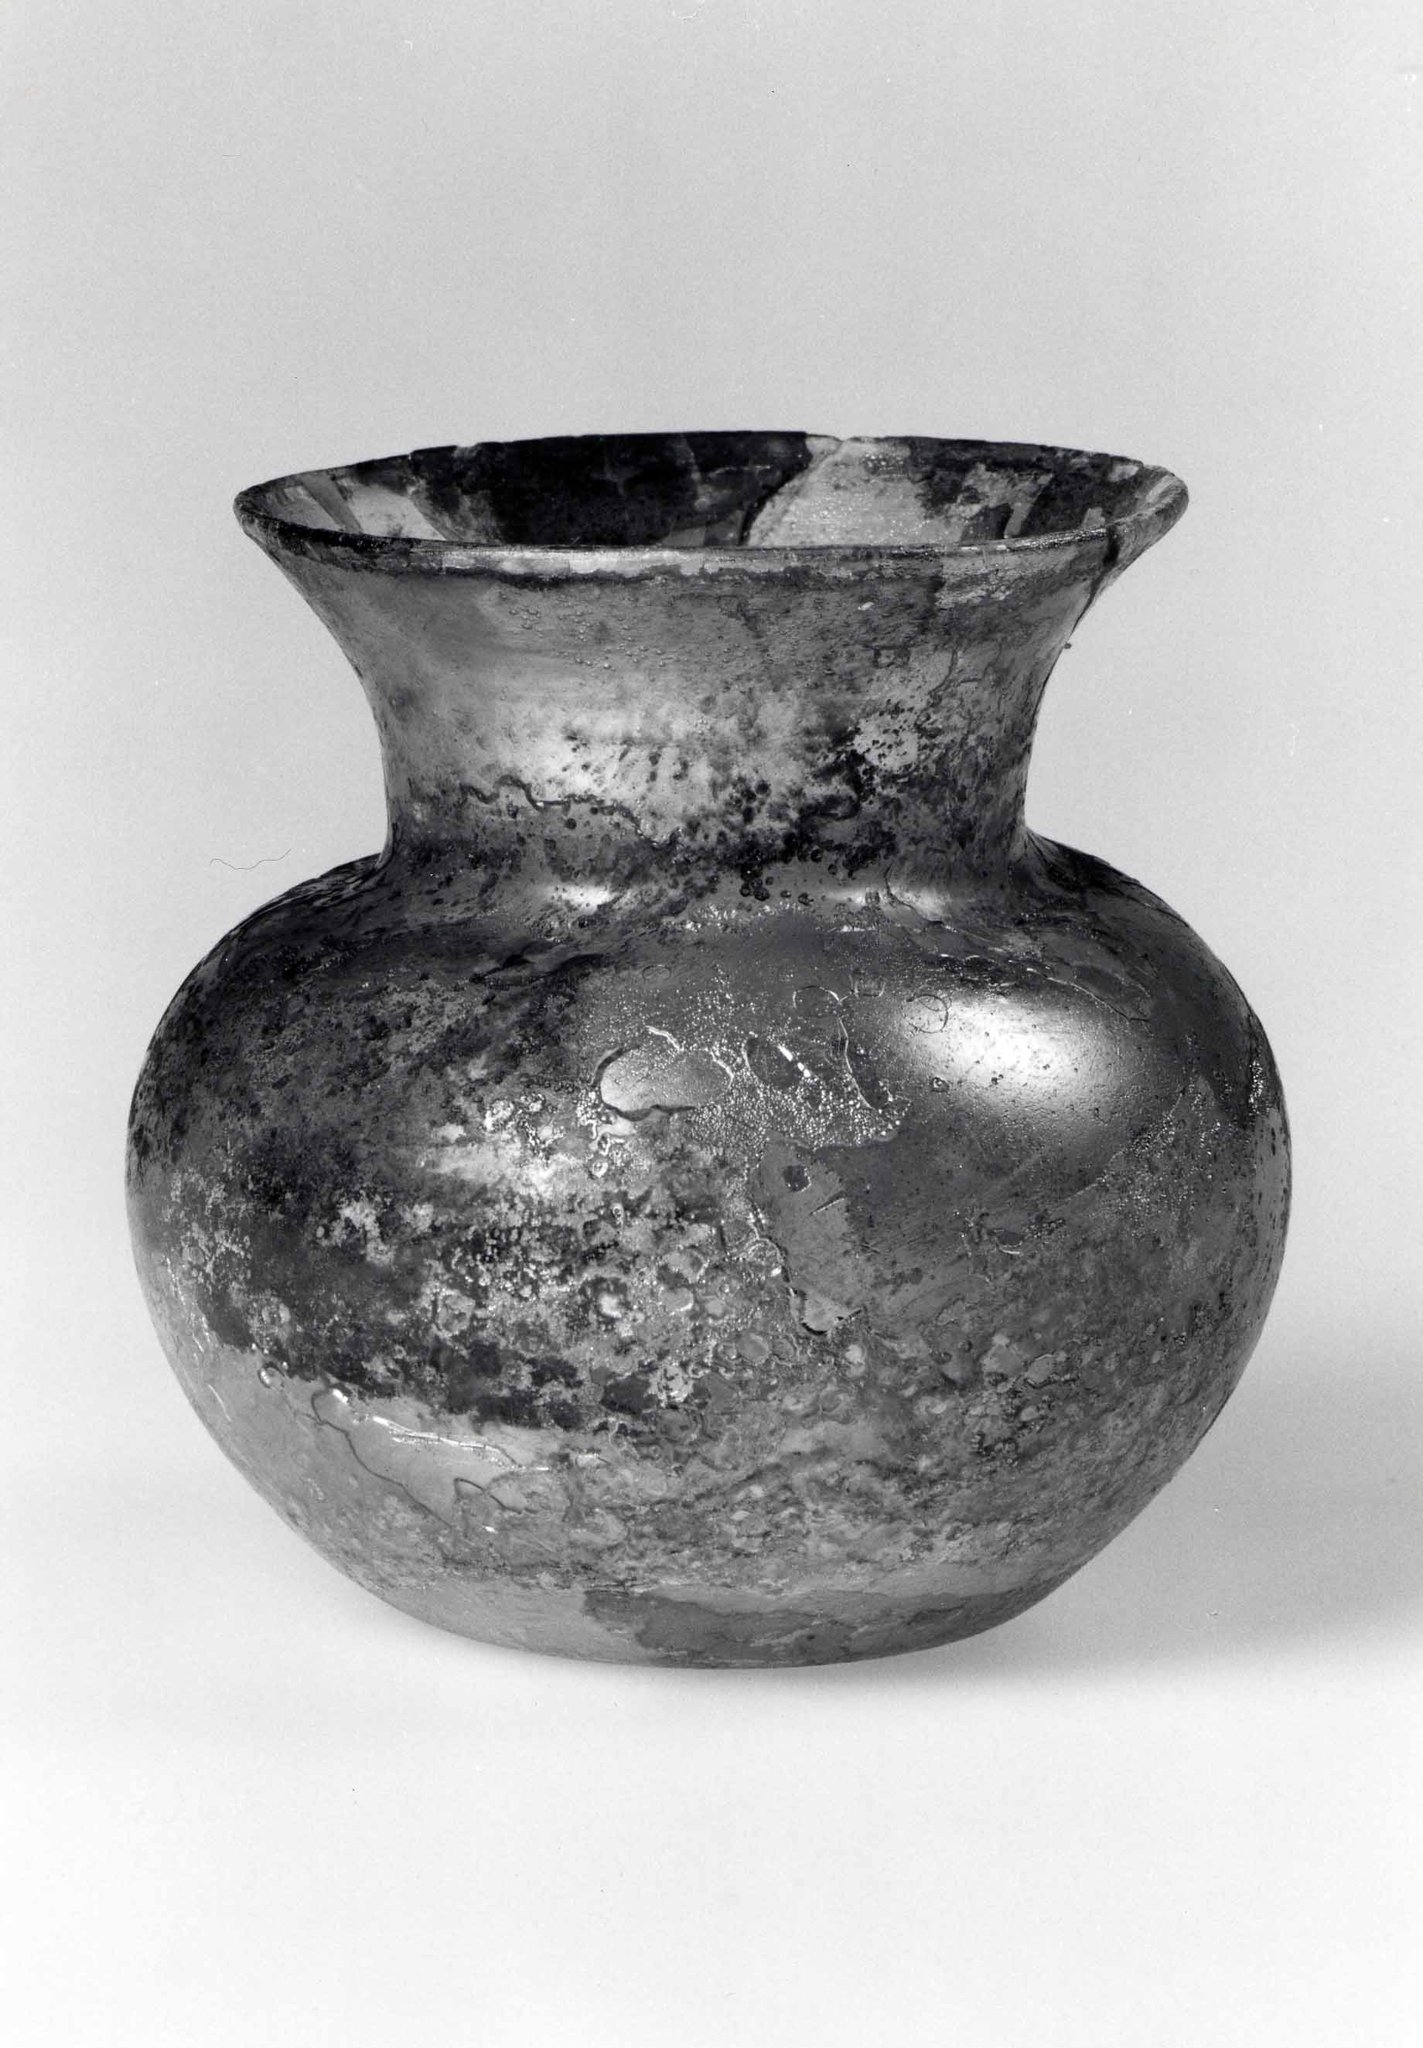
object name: jar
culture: roman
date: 201-400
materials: glass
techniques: glassblowing